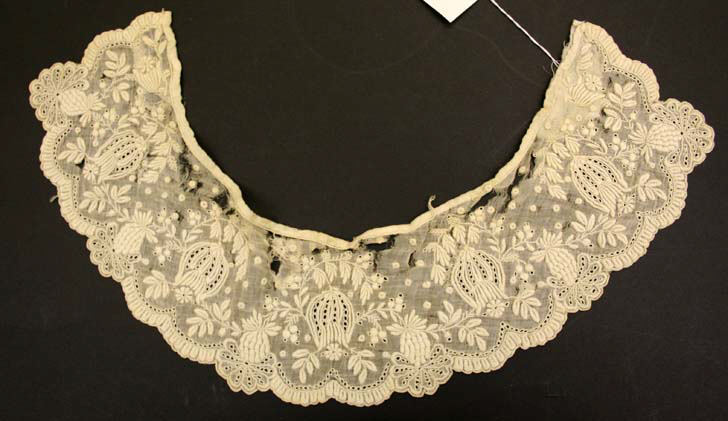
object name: collar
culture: american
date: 1880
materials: cotton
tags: flowers